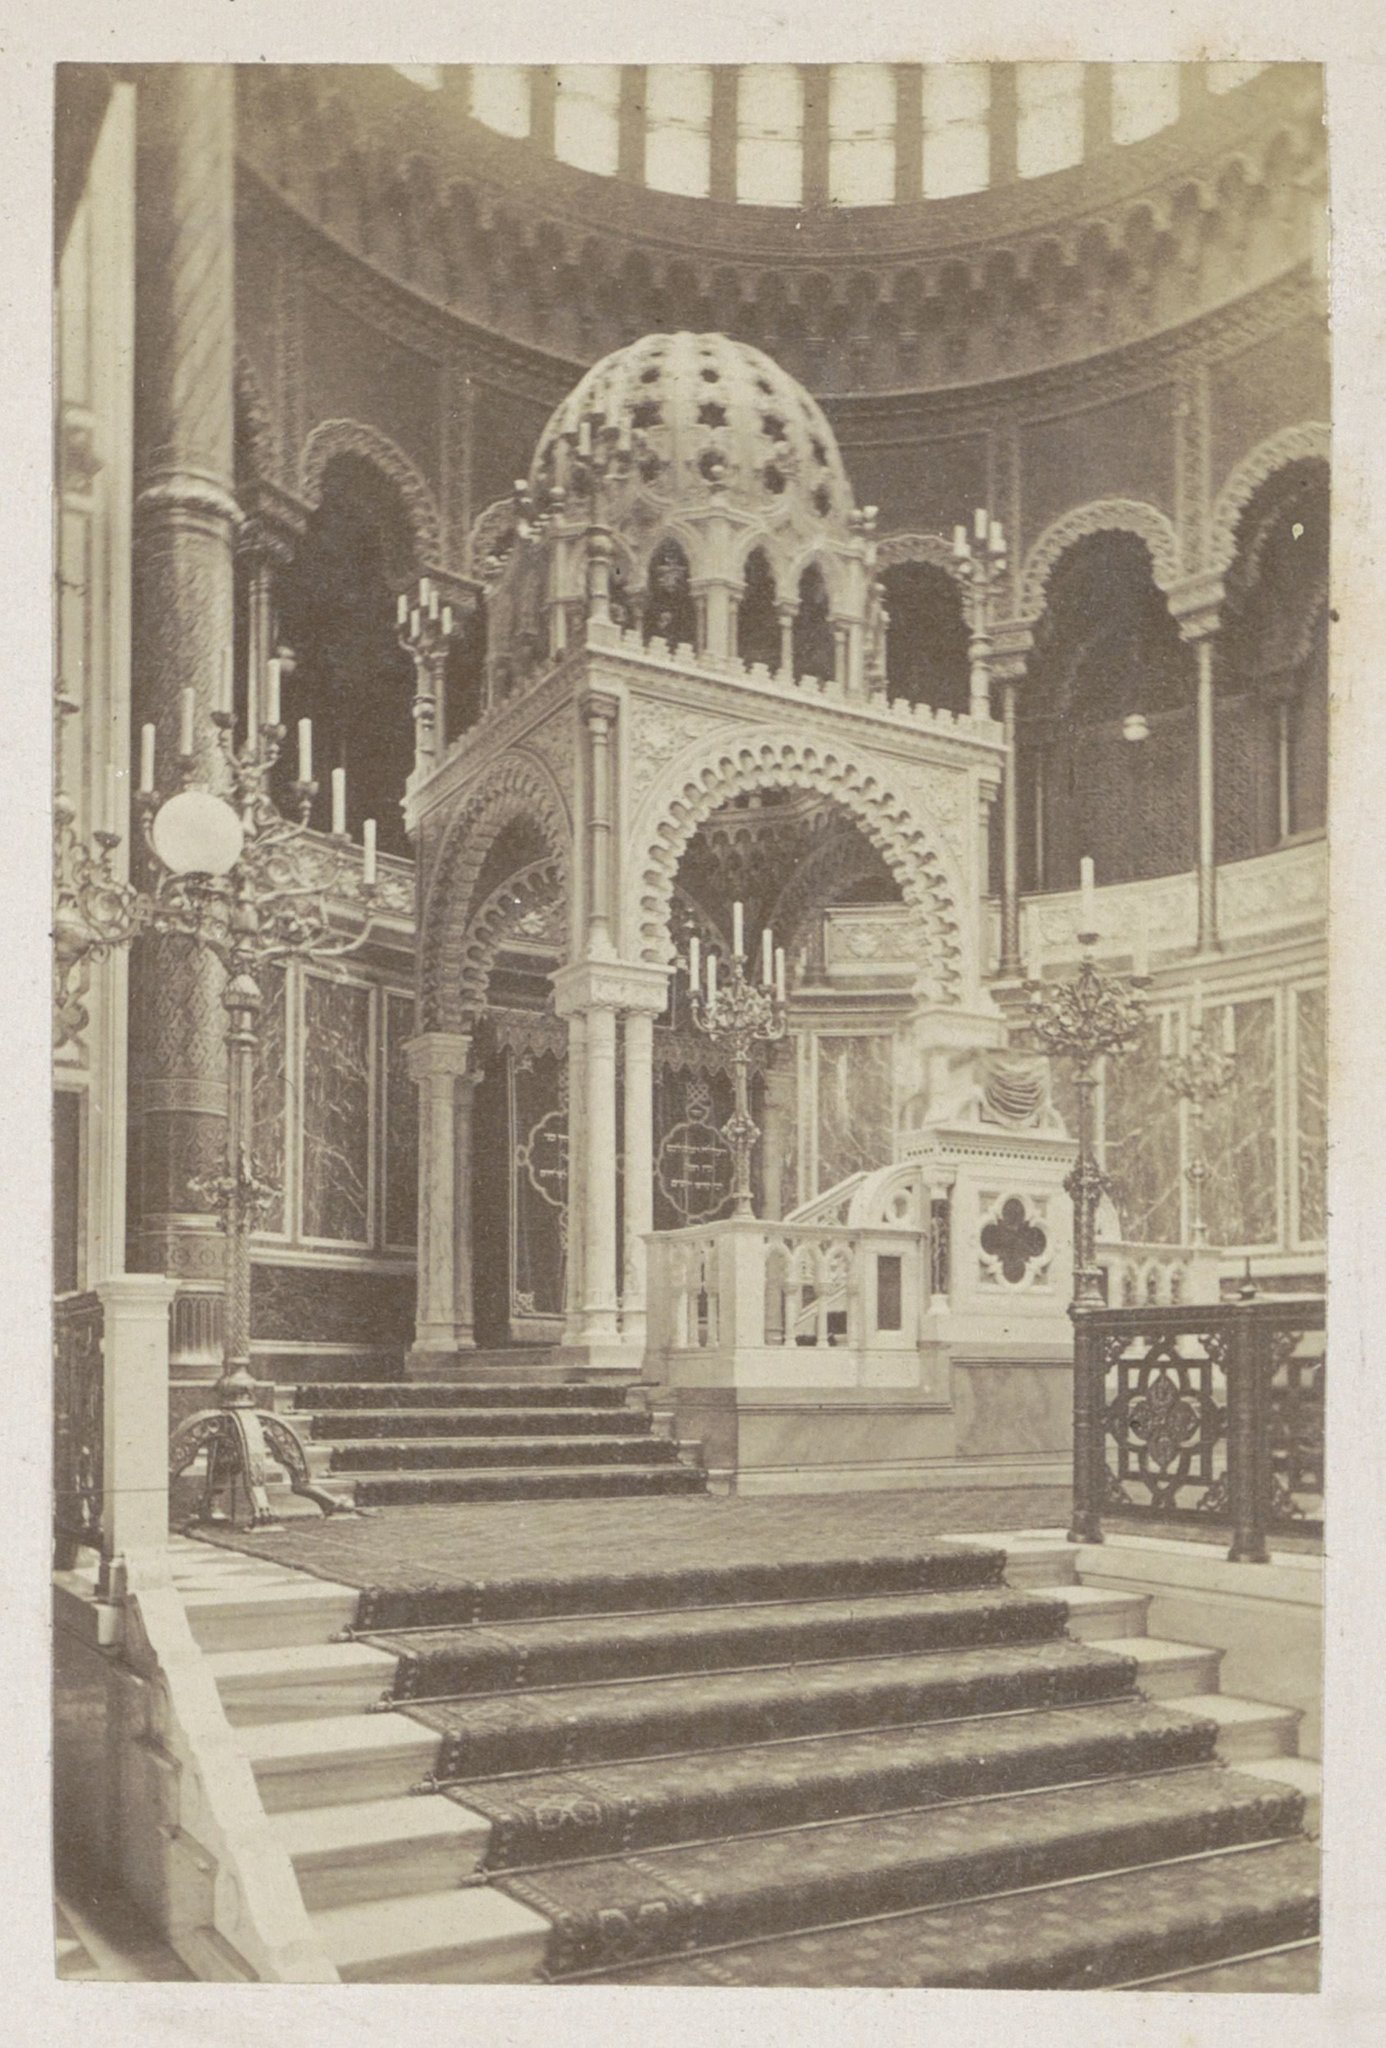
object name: photograph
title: Koor van de Nieuwe Synagoge in Berlijn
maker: Anonymous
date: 1878-1890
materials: photographic support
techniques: albumen print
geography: berlin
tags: choir in synagogue ~ jewish religion, berlin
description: Onderdeel van Reisalbum Europese steden, vermoedelijk Zweeds.